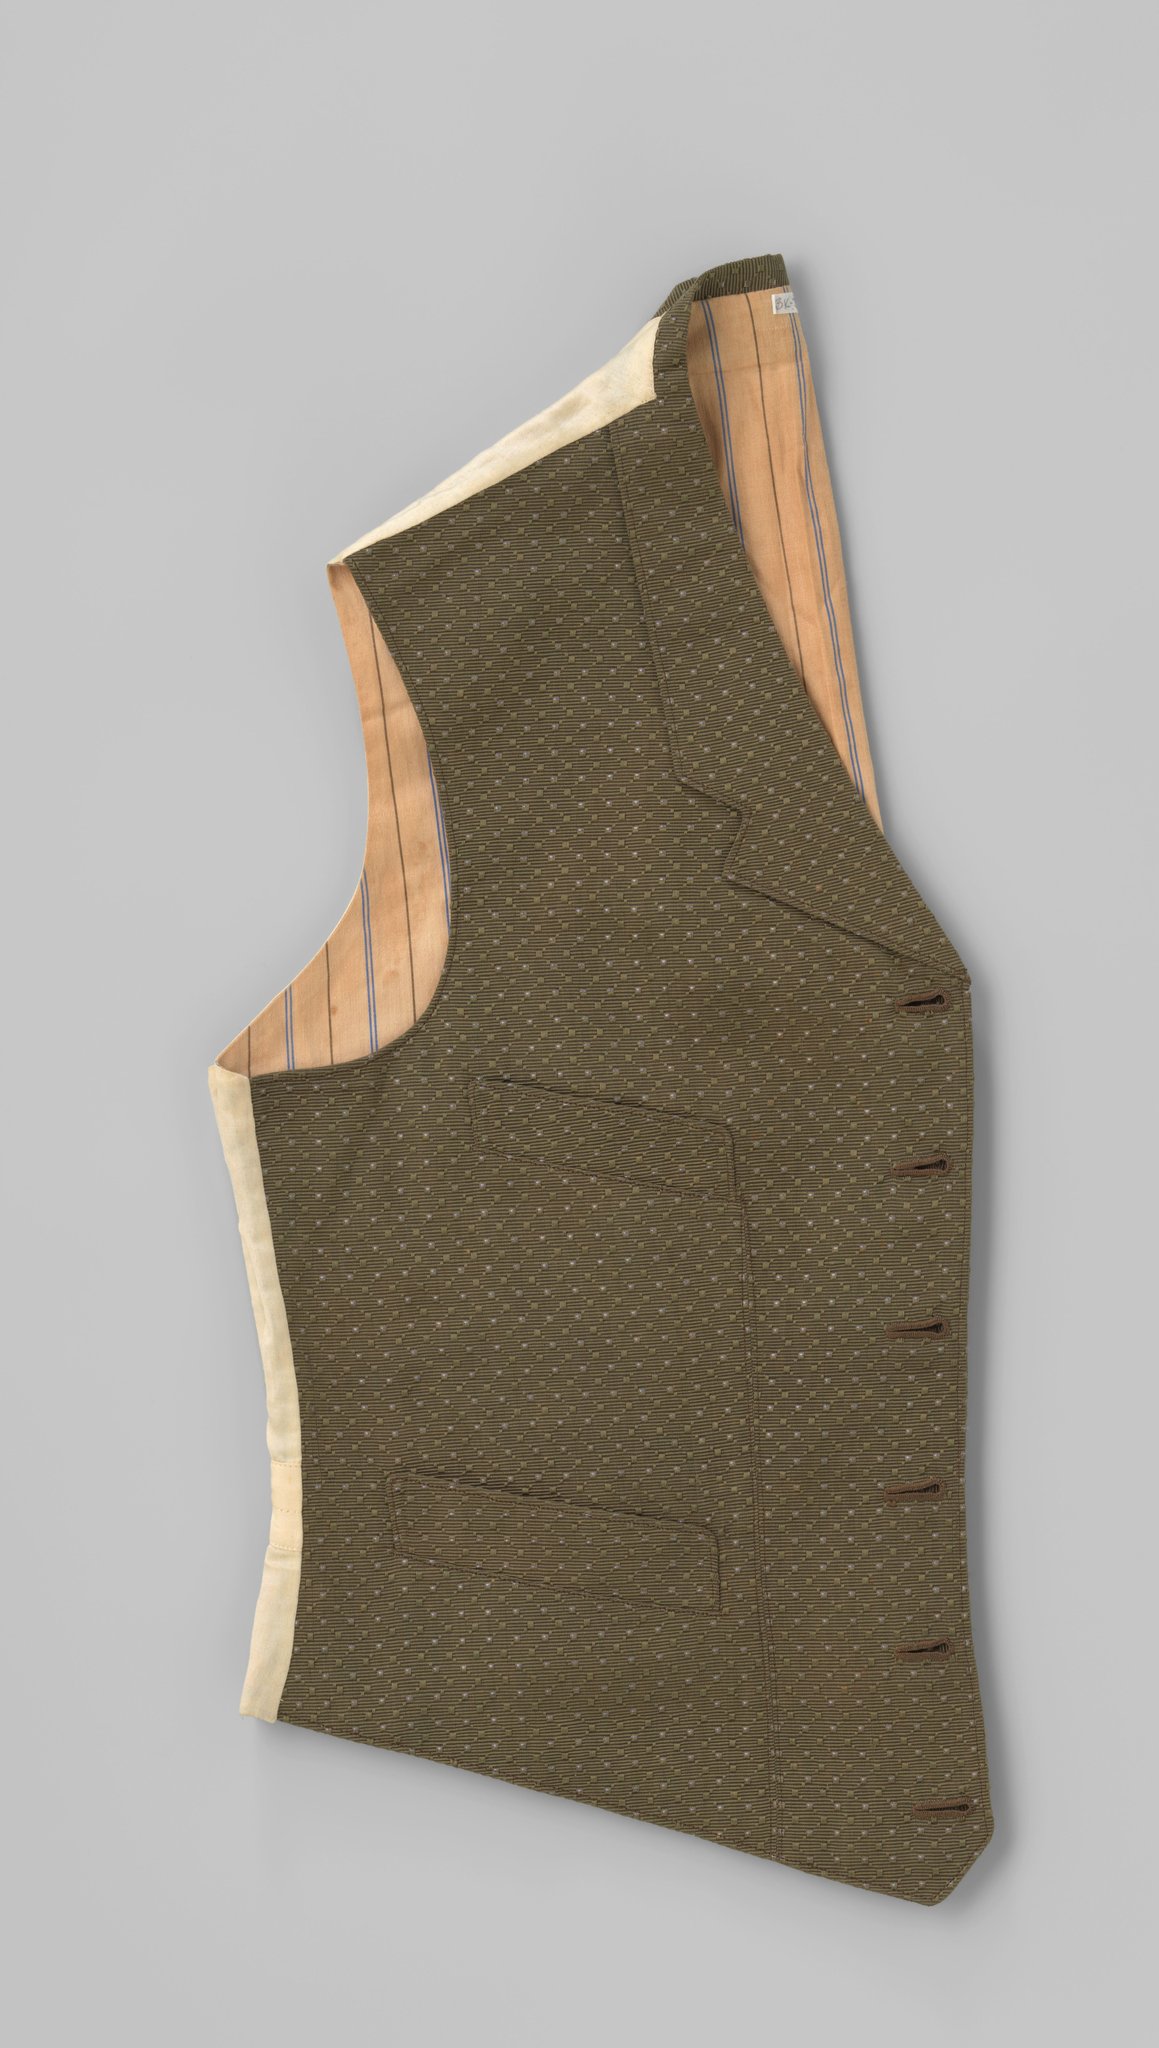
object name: waistcoat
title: Vest met vier zakken, 6 bruine knopen met oranje streep en revers van groene zijde (?) met zigzagranden, onderbroken door groene en groenpaarse blokjes; achter wit katoen.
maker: Anonymous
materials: cotton, silk